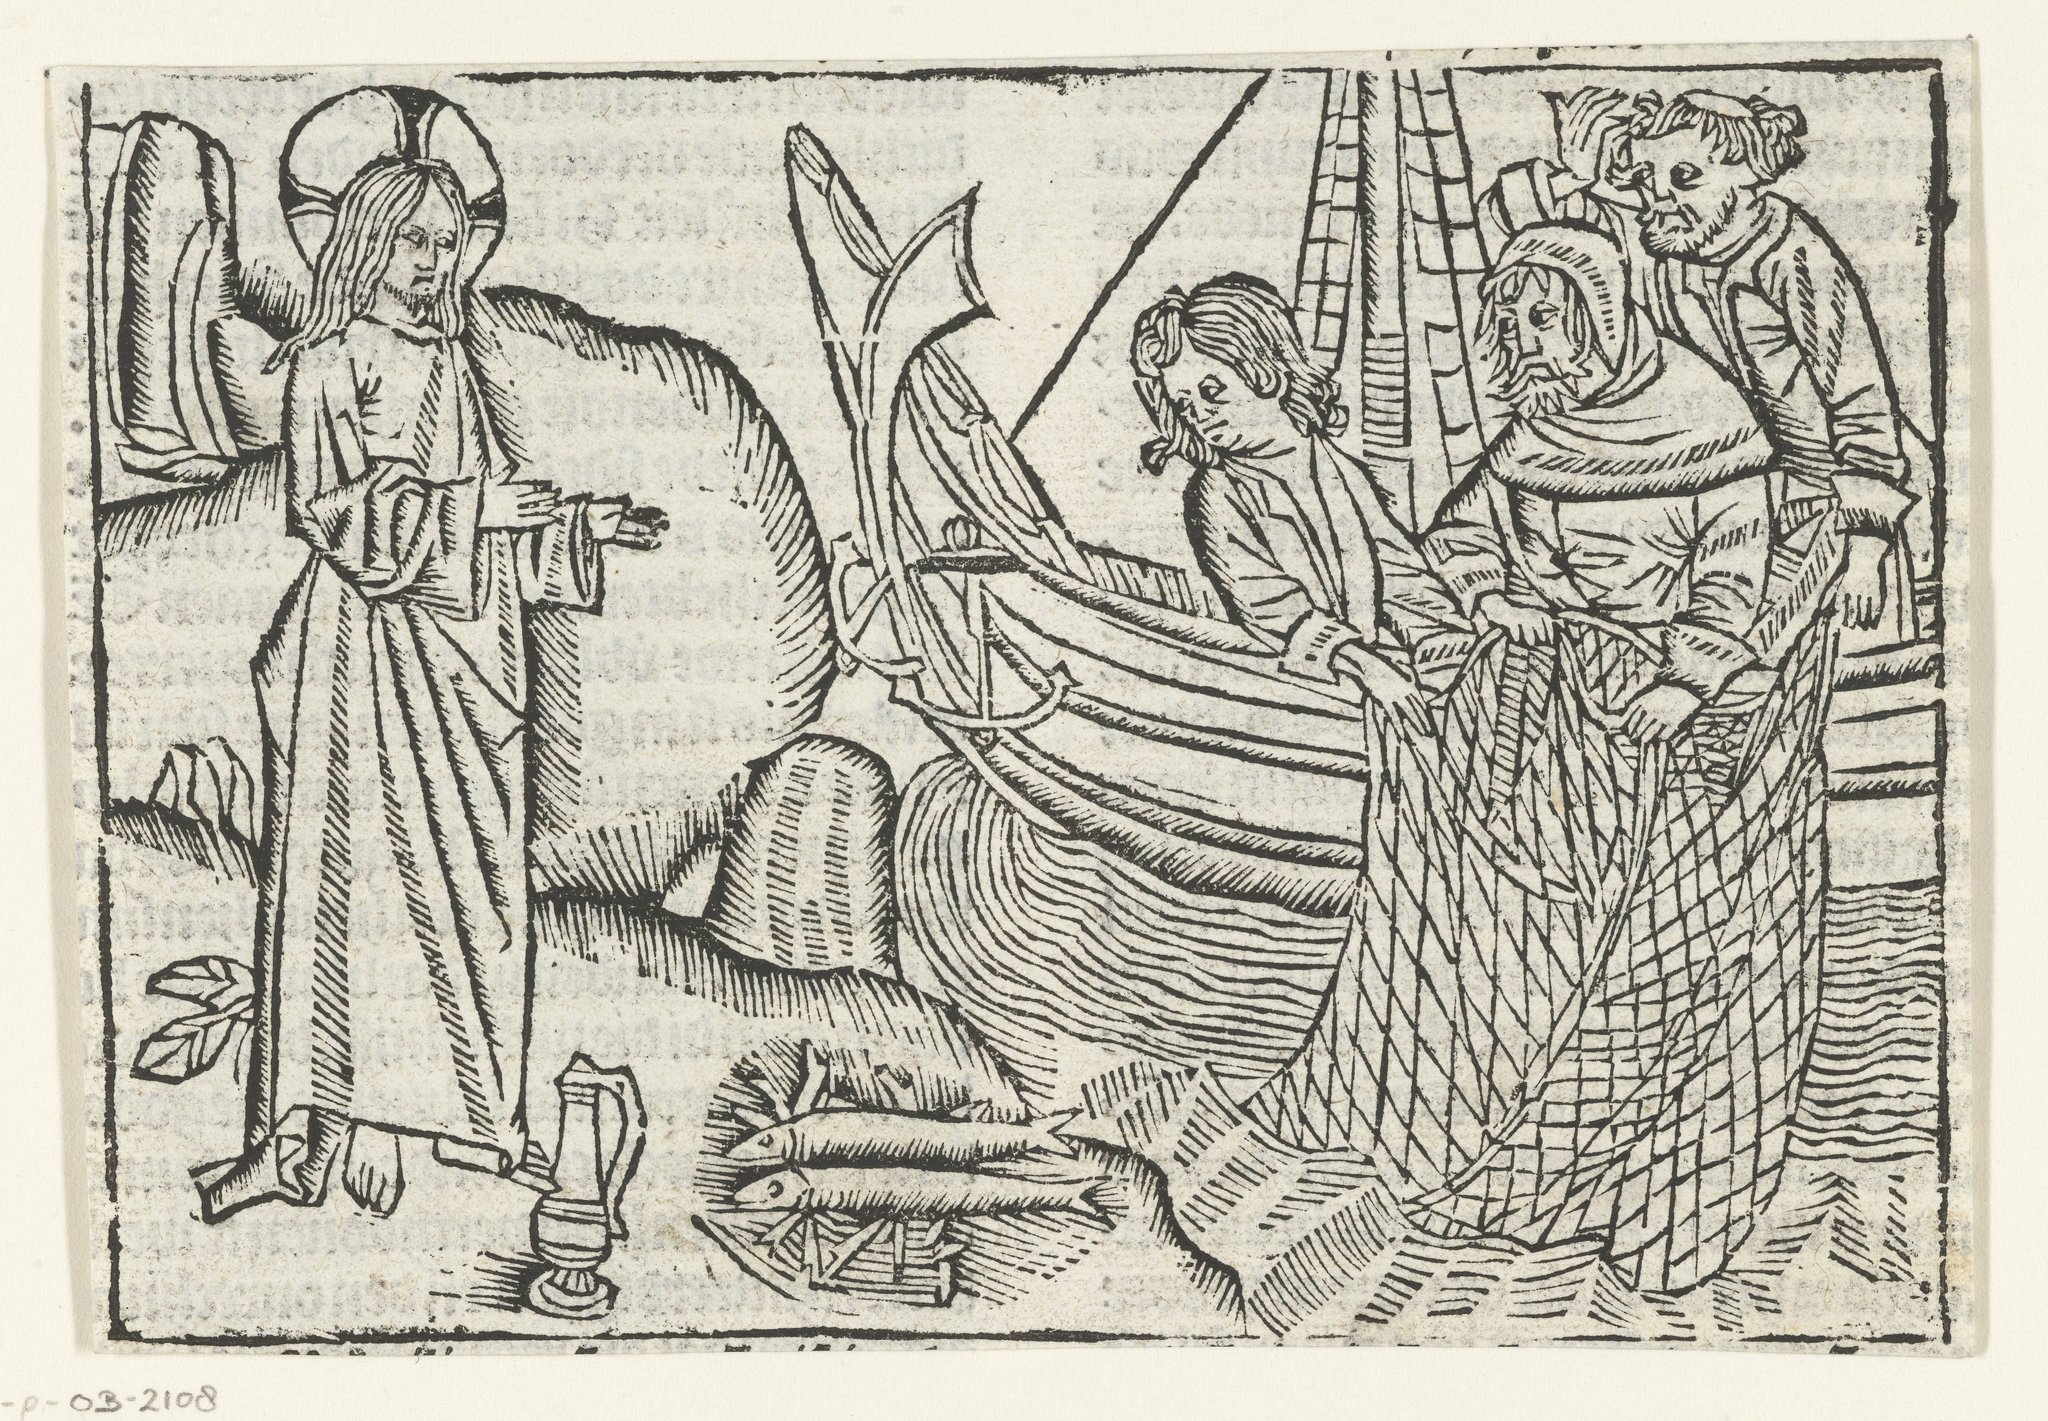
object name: book illustration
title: Wonderbare visvangst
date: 1480-1500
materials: paper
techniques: woodcut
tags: appearance of christ at the lake of gennesaret (sea of galilee, sea of tiberias): miraculous draught of fishes (after the resurrection)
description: Eén blad van 113 uit Ludolphus de Saxonia, "Dit es dleué ons liefs heeren ihesu christi". Anonieme Nederlandse vertaling. Uitgegeven door Henrick Eckert van Homberch te Antwerpen in 1503. Botke, K. Deze 113 houtsneden, die meestal reeds in vroege Nederlandse boeken gebruikt zijn, worden toegeschreven aan de tweede Meester van Delft, de Meester van de Delbecq-Schreiber-passie en de Meester van de Virgo inter Virgines. In Conway (1884) en in "De gulden passer"(1951) zijn ook eerdere versies opgenomen. Botke, K.